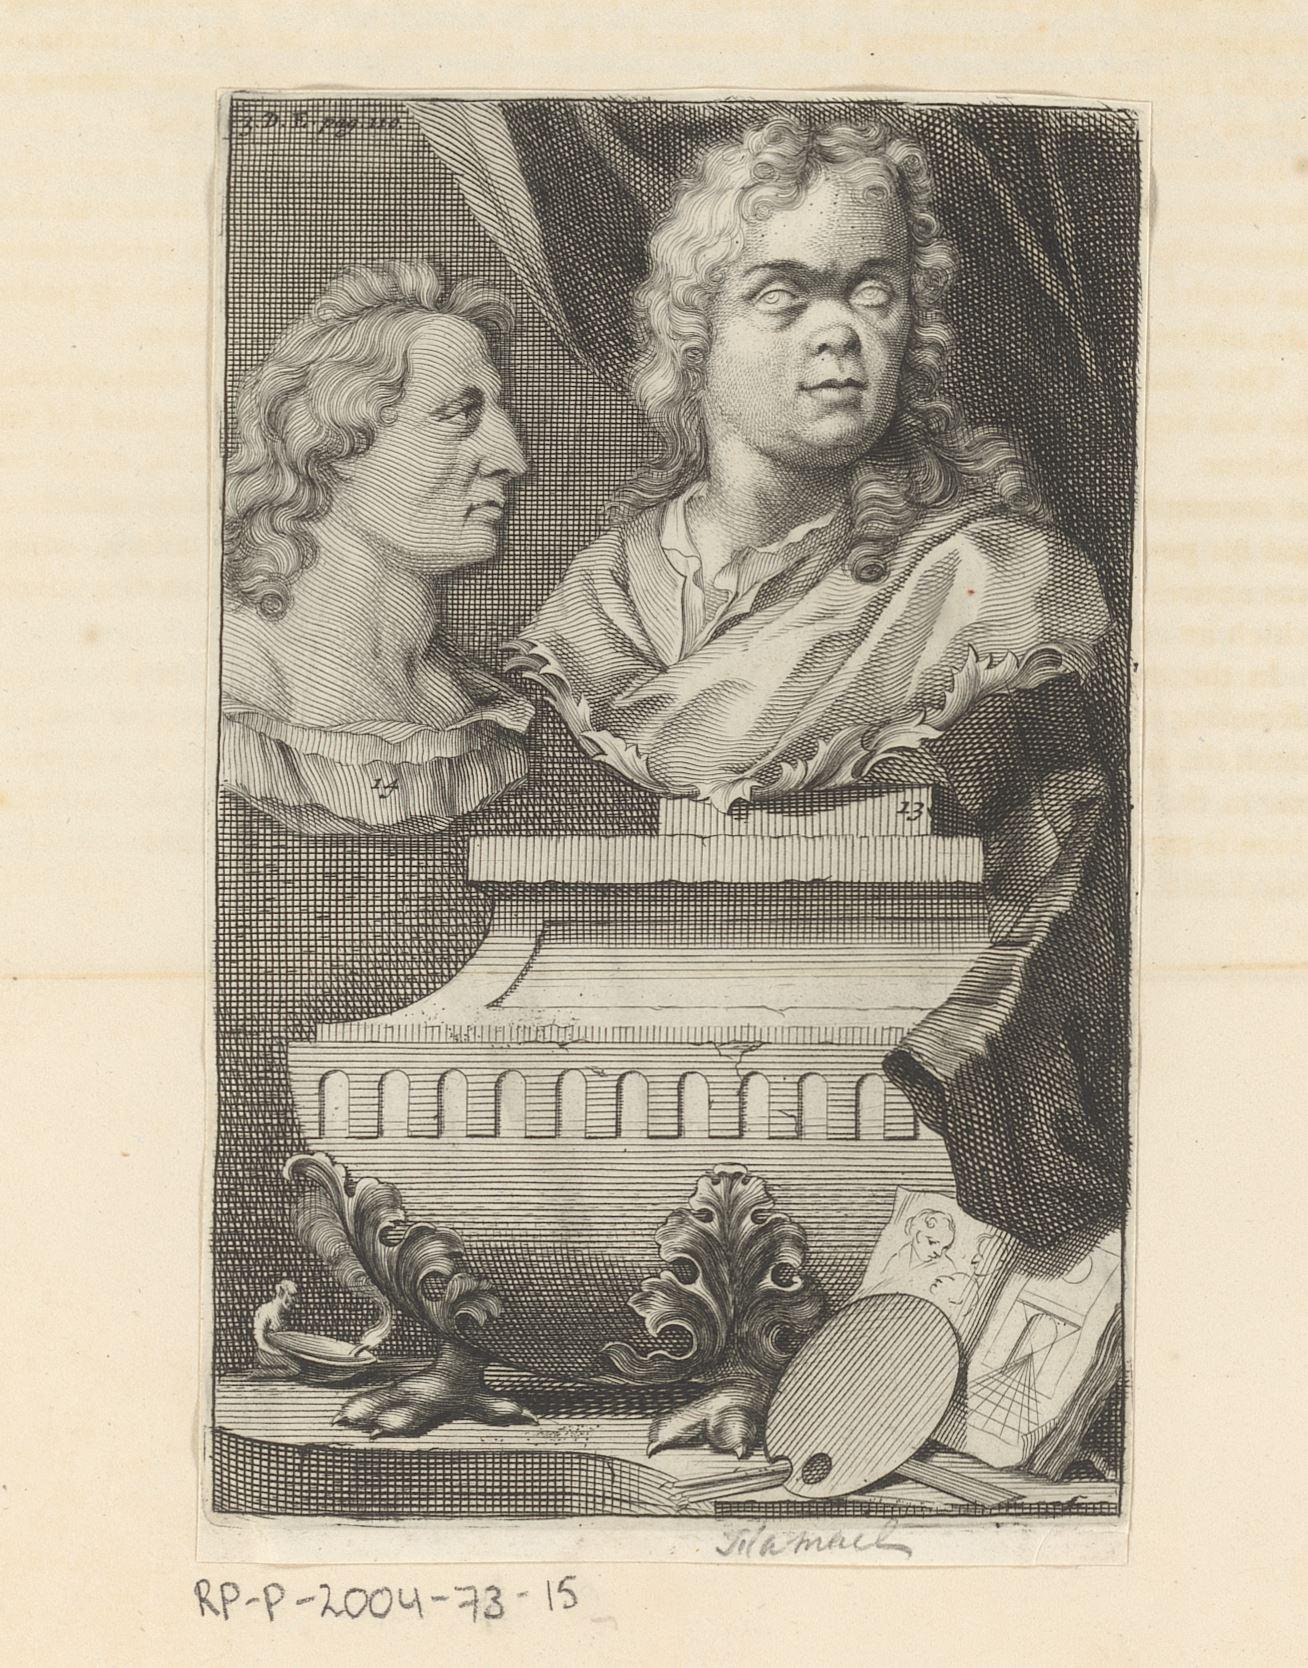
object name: album leaf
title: Portret van Bertholet Flémalle en Gerard de Lairesse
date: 1718-1721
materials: paper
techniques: engraving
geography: amsterdam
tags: bertholet flémalle, liège, amsterdam, painter, print maker, draughtsman, gerard de lairesse, historical persons, portrait, self-portrait of painter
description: Prent uit: Houbraken, Arnold. De groote schouburgh der Nederlantsche konstschilders en schilderessen (...). 3 dln. Amsterdam: Antonina Houbraken, 1721, dl. 3, p. 110. Prent mogelijk ook gebruikt in een eerdere (1718) publicatie. De samensteller heeft deze prent in het album geplakt als illustratie bij: Pilkington, Matthew en Johann Heinrich Füssli. A dictionary of painters, from the revival of the art to the present period. 4 dln. Londen: John Crowder, 1805, dl. 2, p. 187.